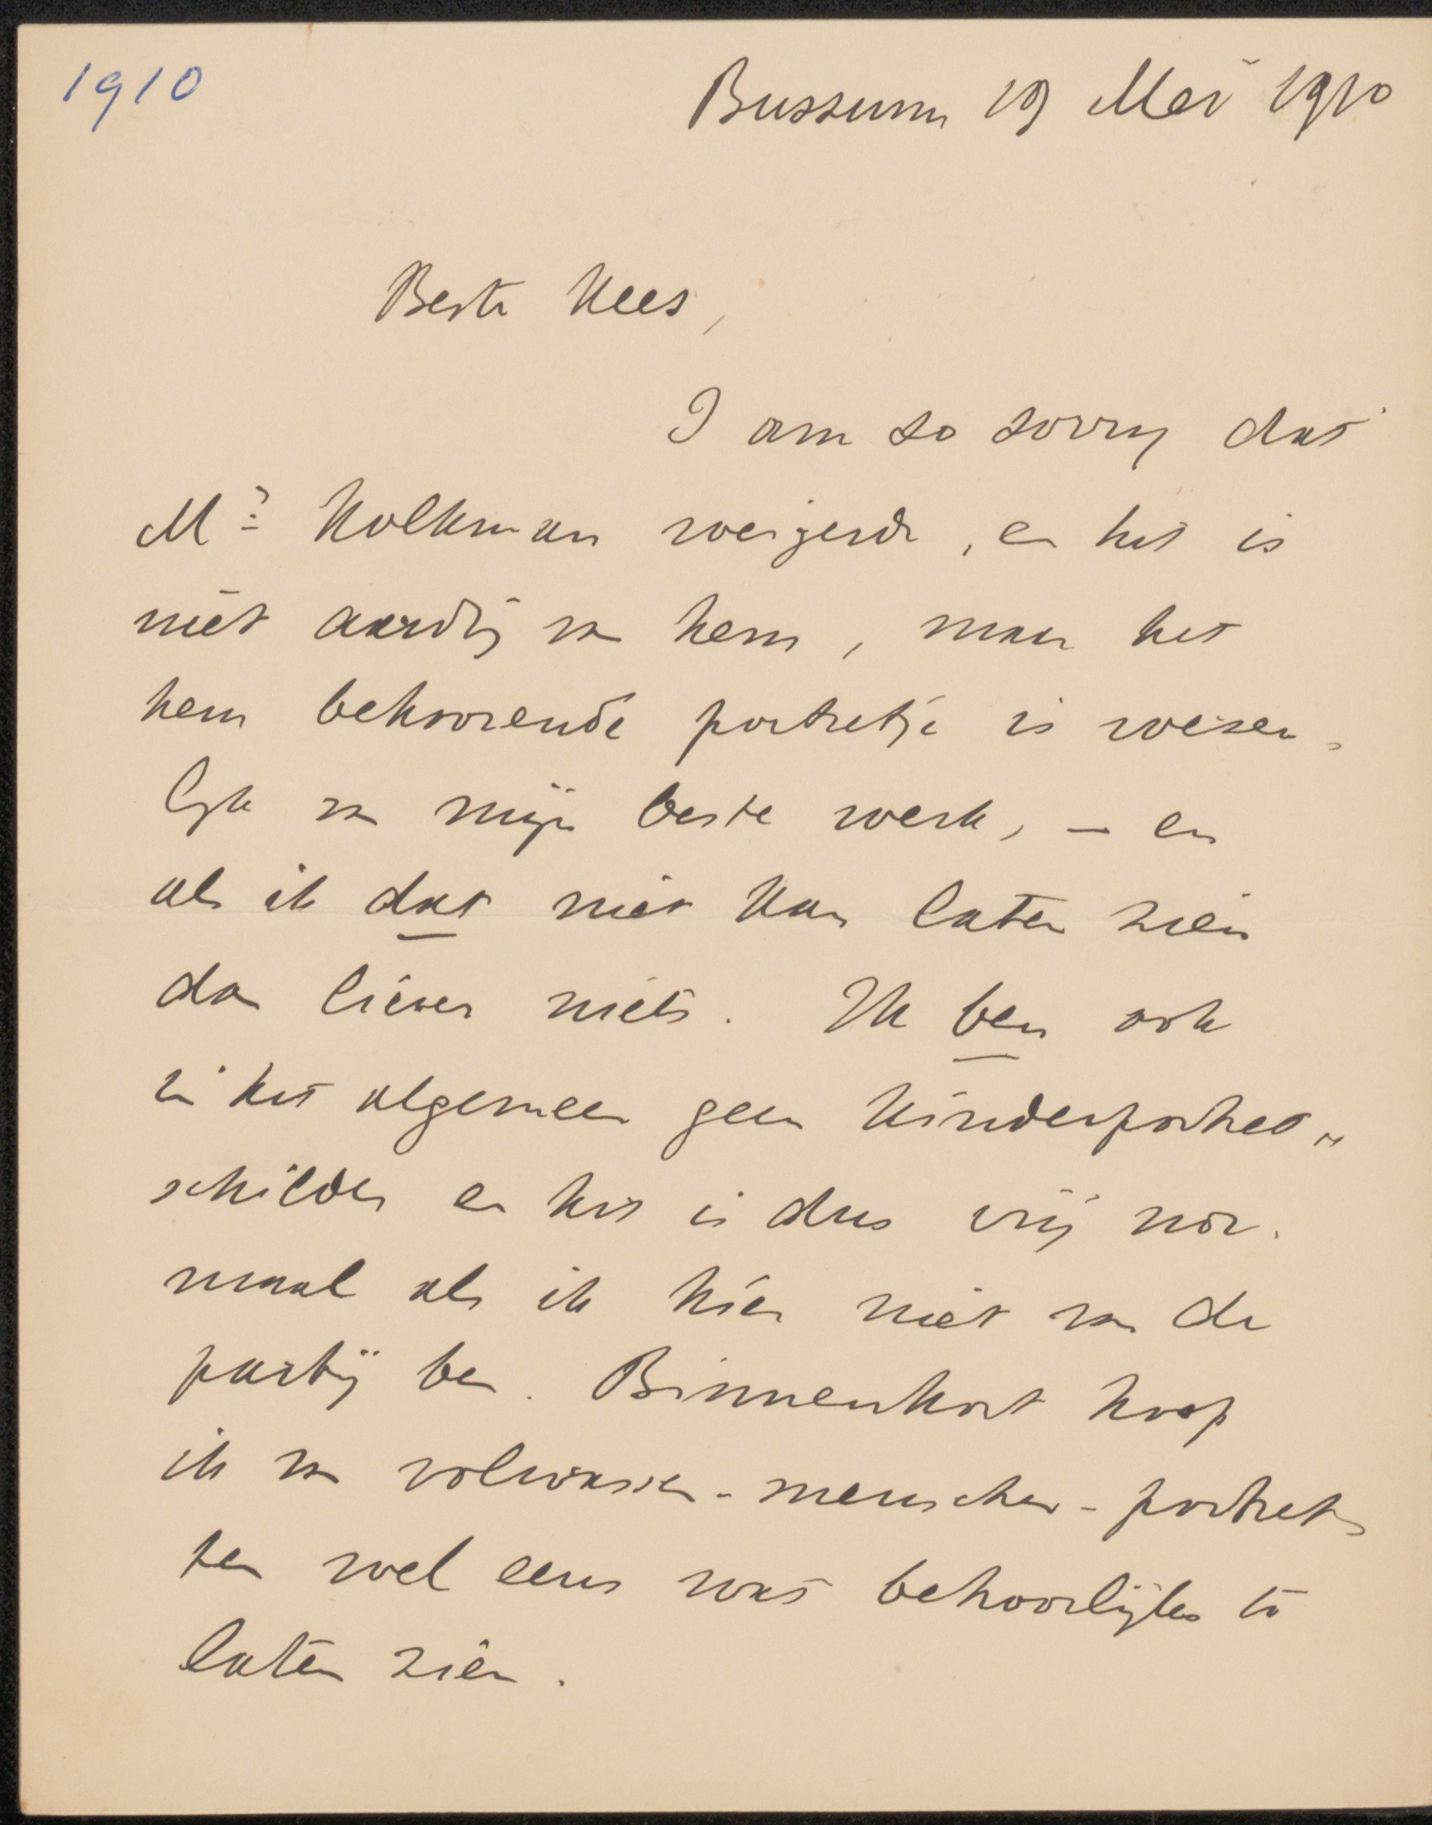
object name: letter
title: Brief aan Cornelis Gerardus 't Hooft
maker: jan veth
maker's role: designer, draughtsman, painter, print maker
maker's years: 1864-1925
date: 1910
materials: ink, paper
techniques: pen, writing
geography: bussum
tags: cornelis gerardus 't hooft, historical persons (portraits and scenes from the life)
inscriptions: watermark, collector's mark: ‘RPK’